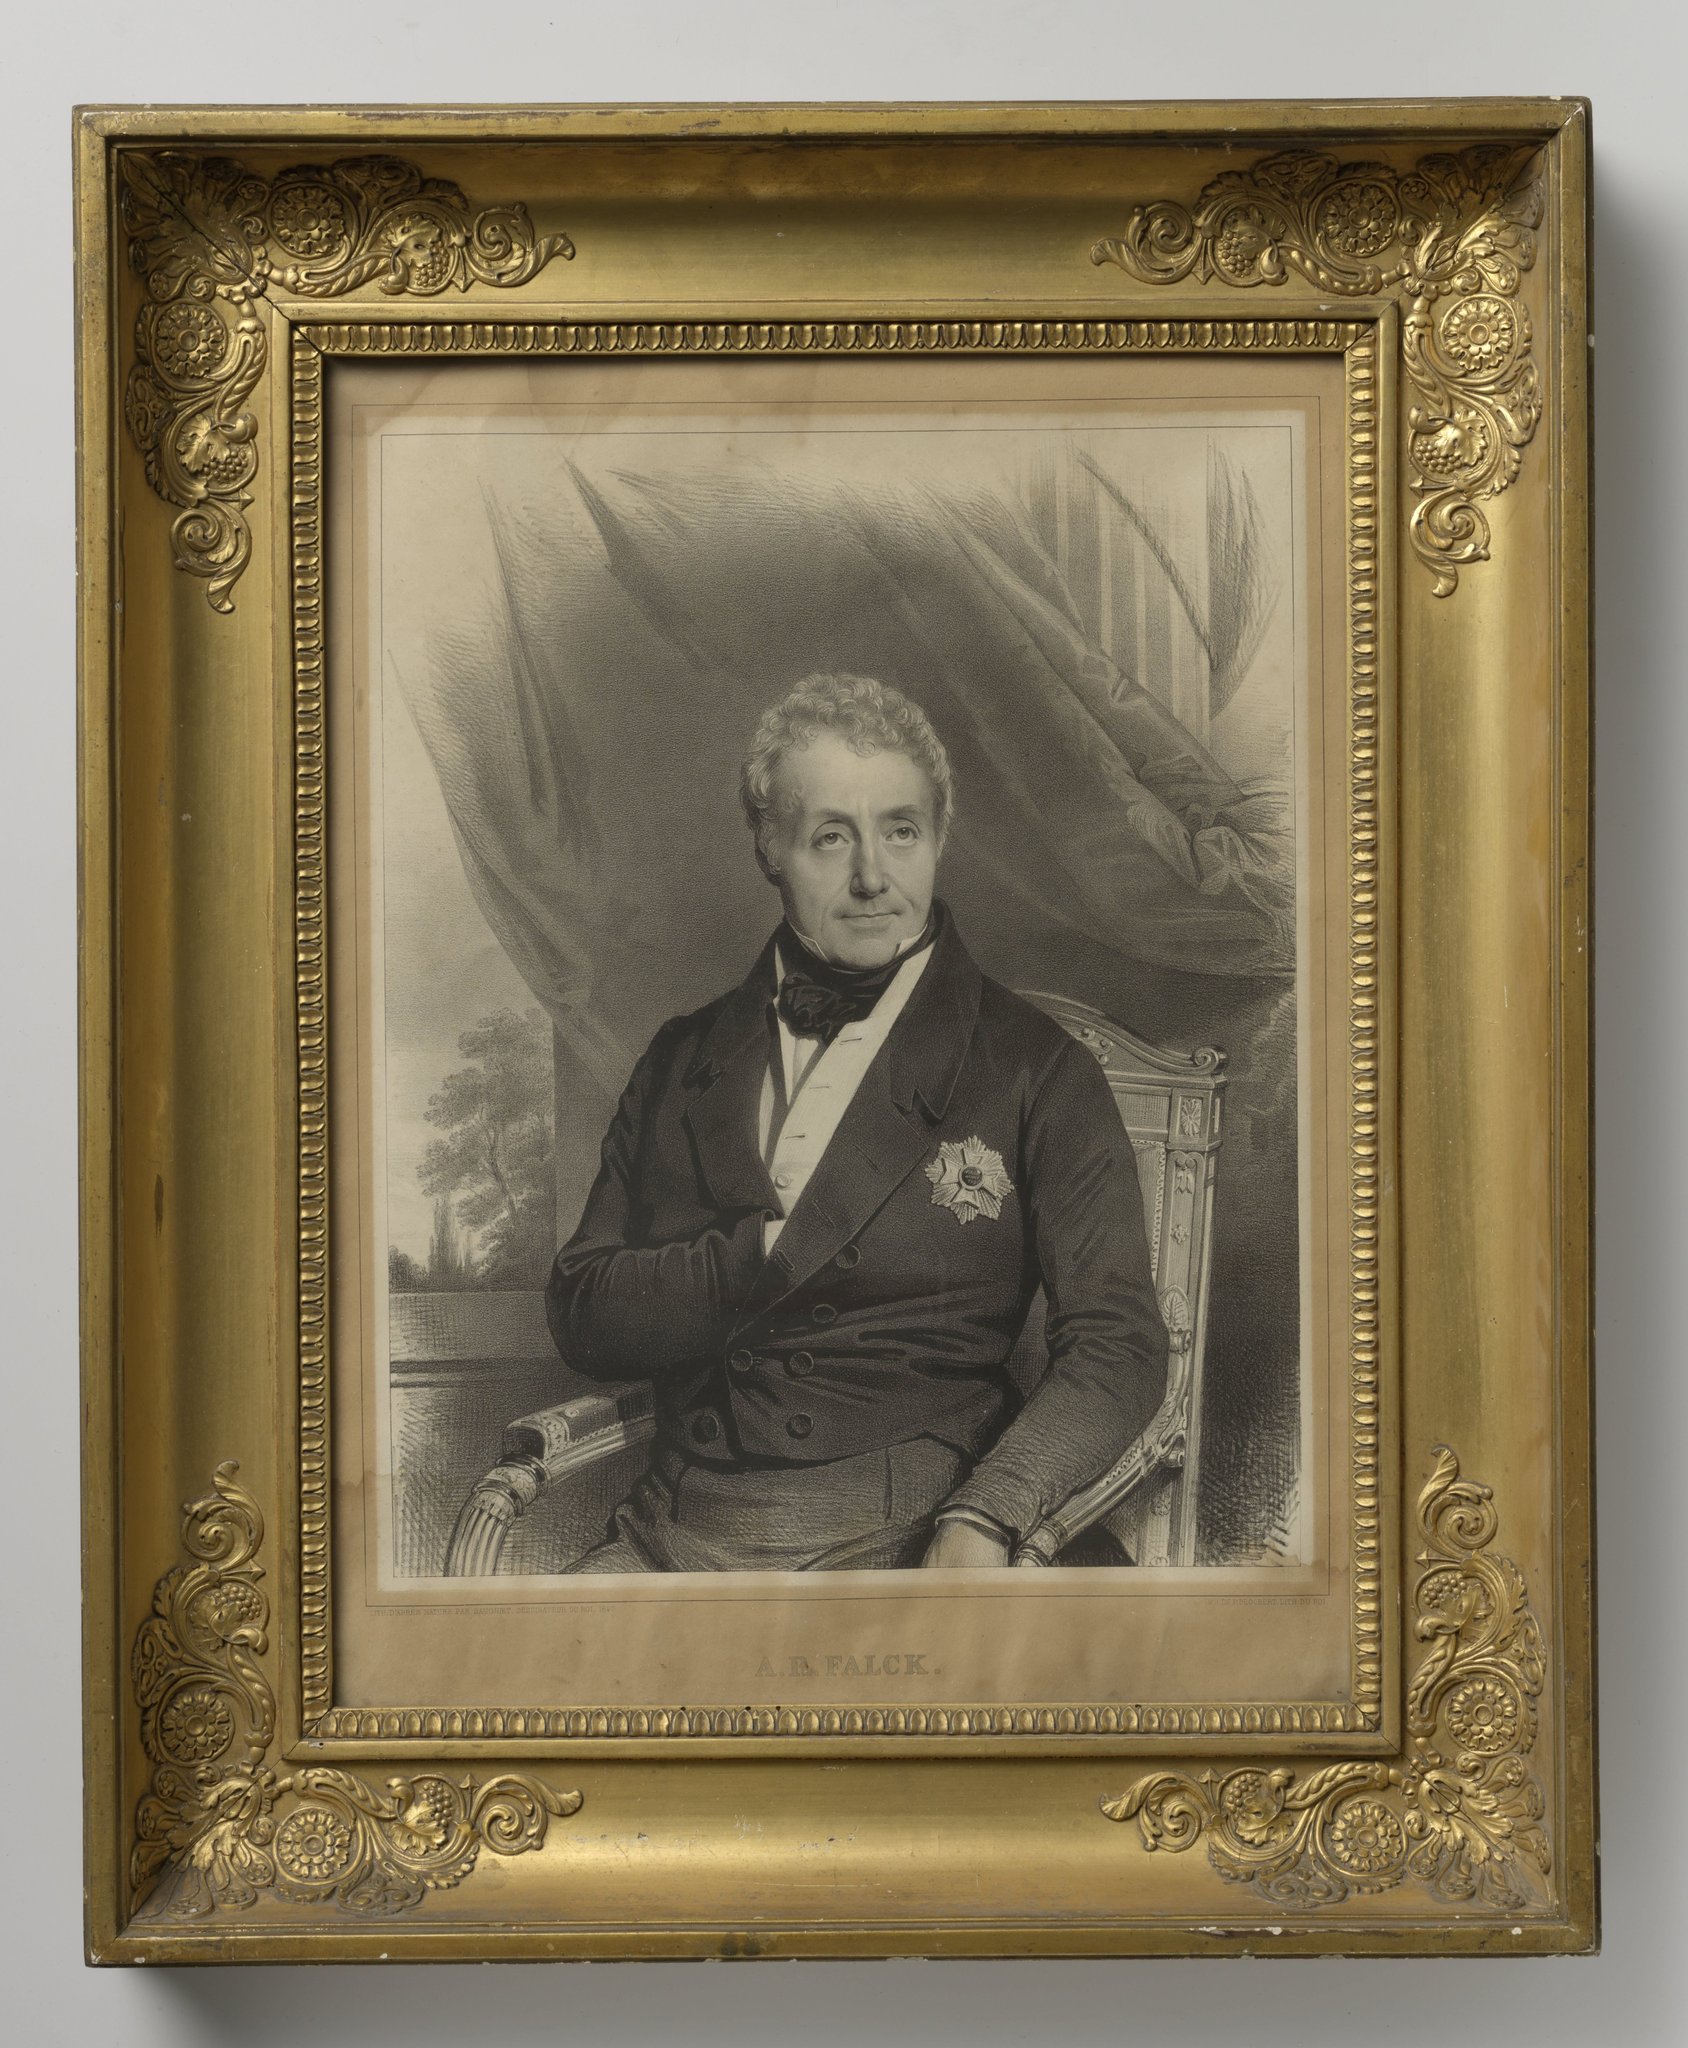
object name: print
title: A. R. Falck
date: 1842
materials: glass, metal, paper, wood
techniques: framing, gilding, lithograph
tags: brussels, anton reinhard falck, minister ~ government, historical persons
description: Portret van Anton Reinhard Falck, zittend in een stoel naar links, rechterhand in revers, op linkerborst ereteken, achtergrond half open gordijn en links doorzicht door raam van aantal bomen. In vergulde empirelijst.